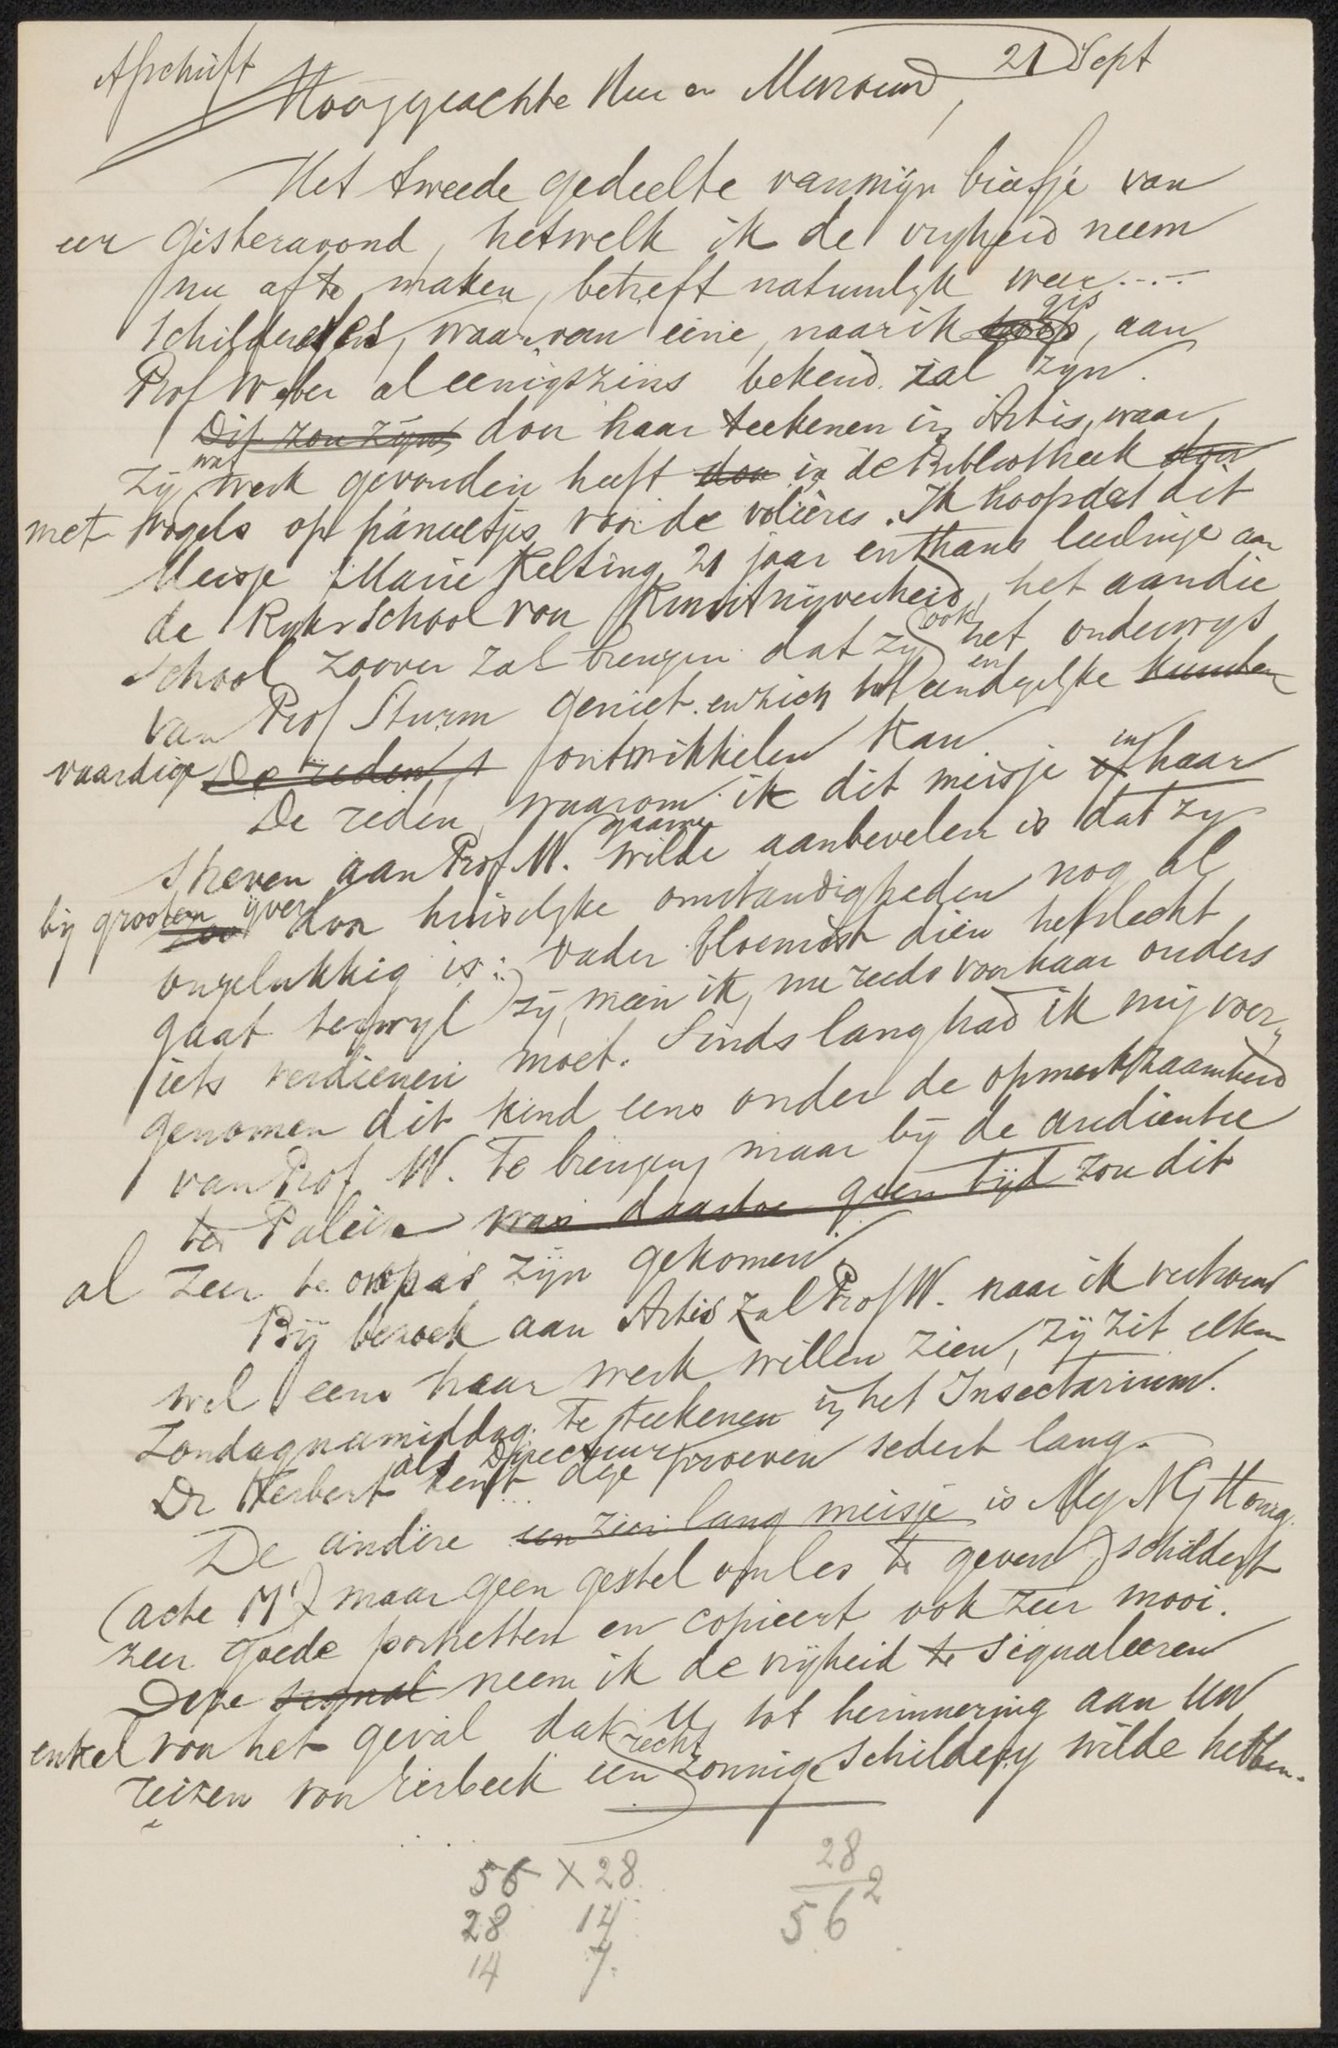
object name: letter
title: Brief aan anoniem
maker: august allebé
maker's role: draughtsman, print maker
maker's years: 1838-1927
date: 1848-1927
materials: ink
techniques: pen, writing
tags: anne antoinette weber-van bosse, amsterdam, vleuten, print maker, marie kelting, vienna, georg sturm, anonymous historical person portrayed, education, tuition of the artist (in general), painting (including book-illumination, miniature-painting)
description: Afschrift van een brief, gedateerd 21 september en waarschijnlijk gericht aan Max Wilhelm Carl Weber en Anne Antoinette Weber-Van Bosse.